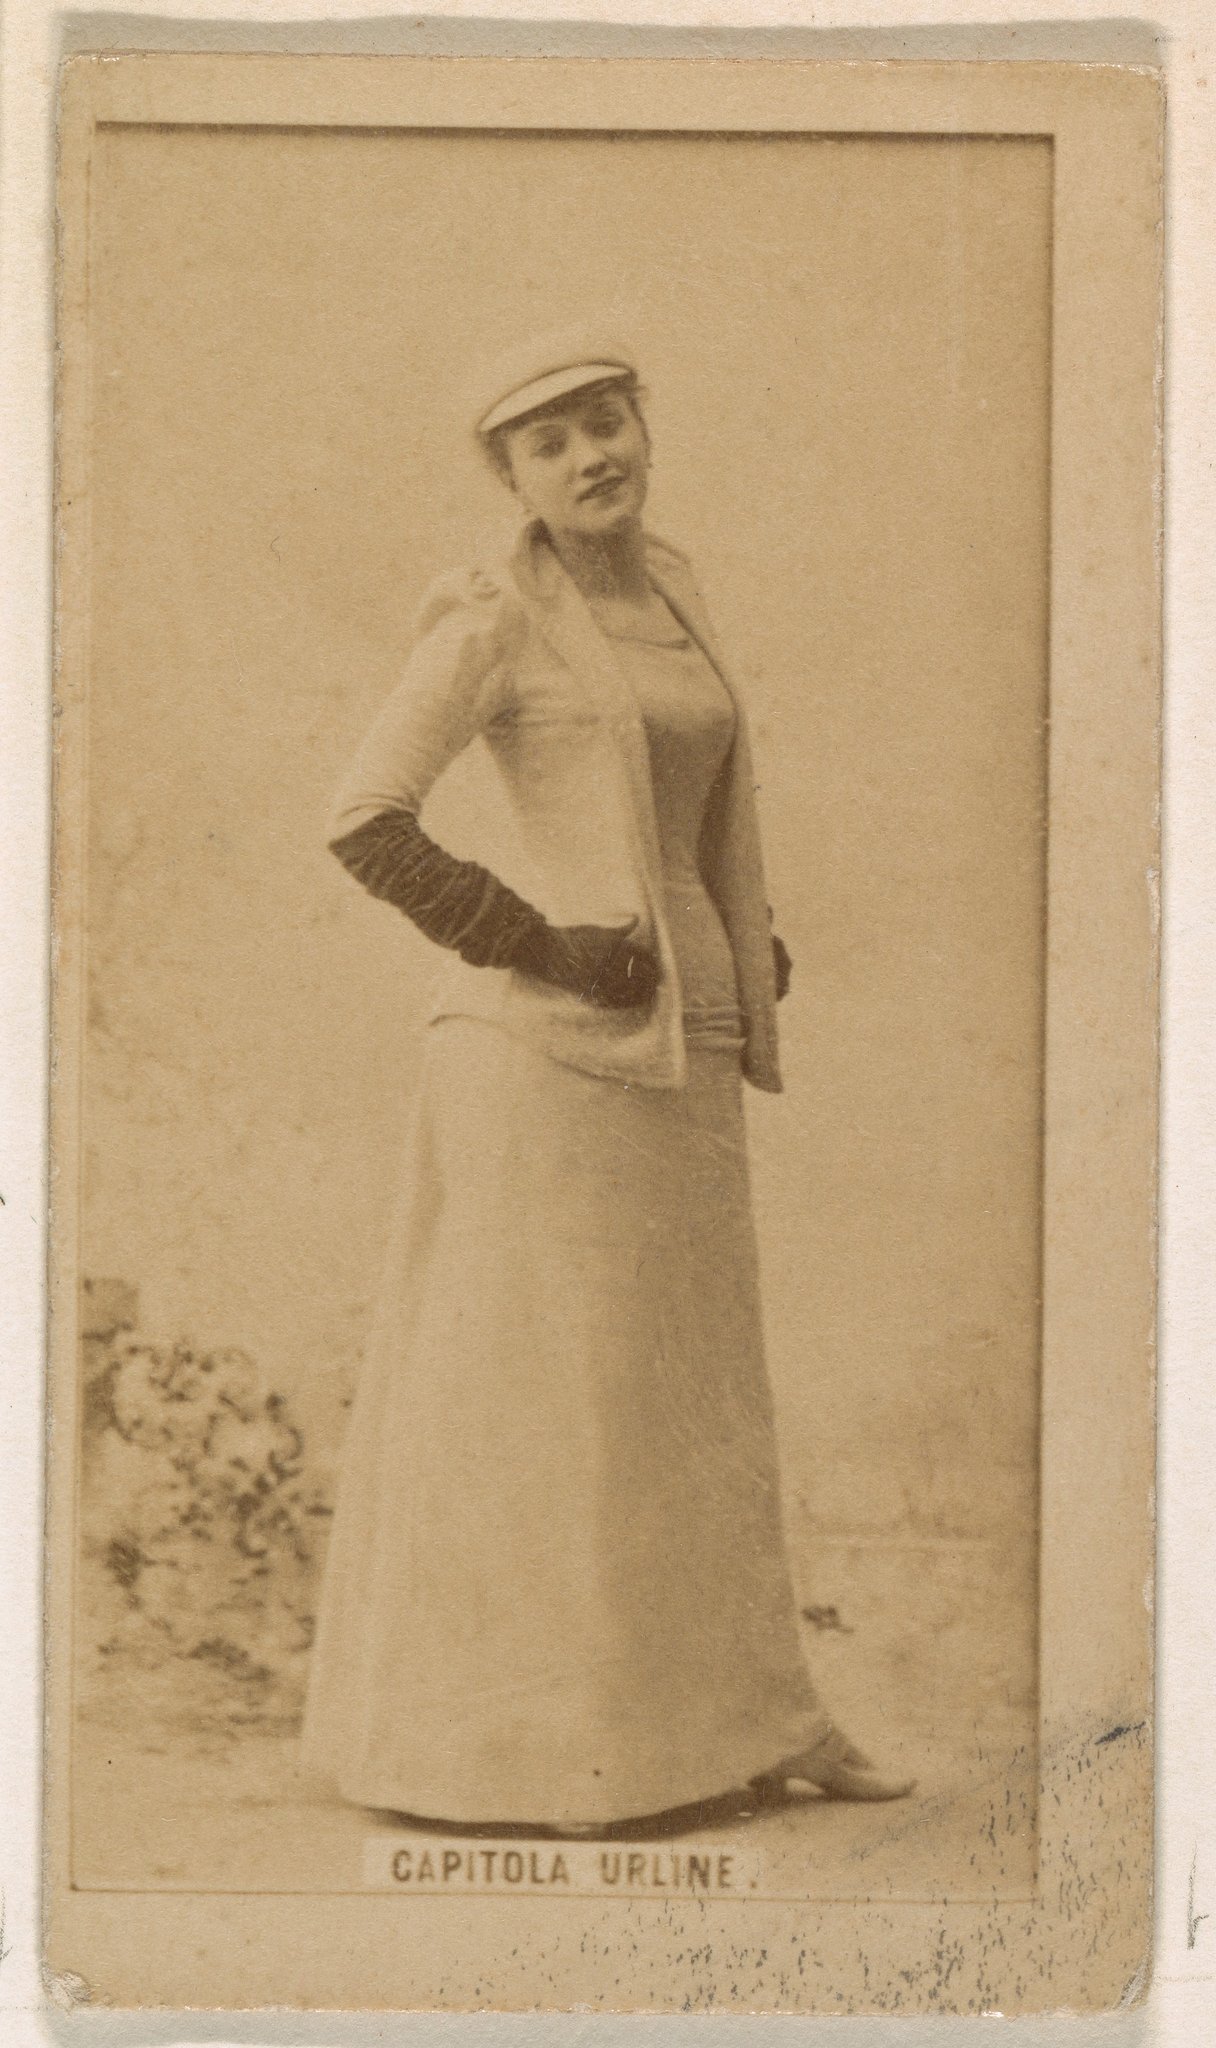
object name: photograph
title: Capitola Urline, from the Actresses series (N245) issued by Kinney Brothers to promote Sweet Caporal Cigarettes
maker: kinney brothers tobacco company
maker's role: publisher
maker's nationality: american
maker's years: 1869-2011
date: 1890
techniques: albumen silver print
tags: portraits,women,actresses